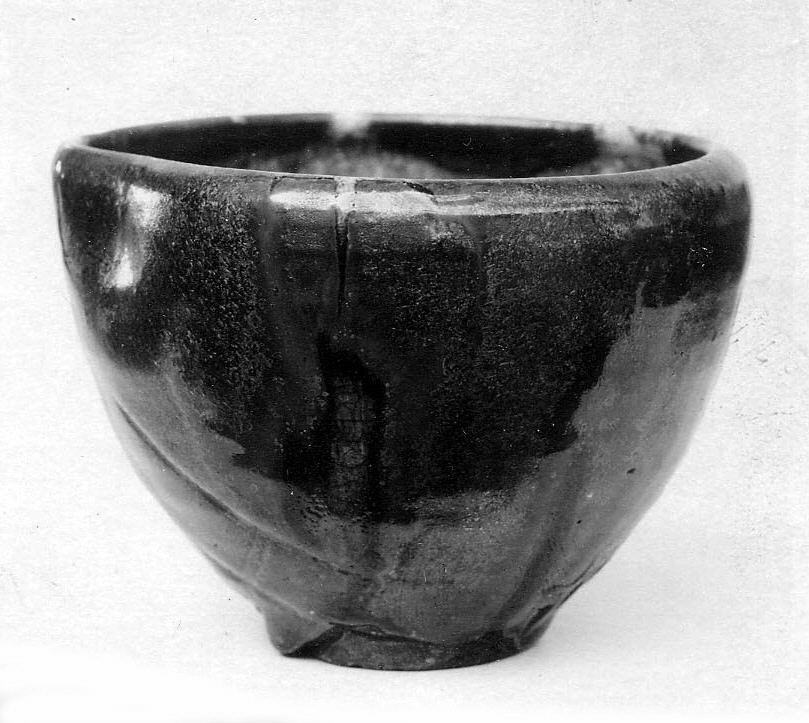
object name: teabowl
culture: japanese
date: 1701-1800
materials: glaze, pottery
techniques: incising